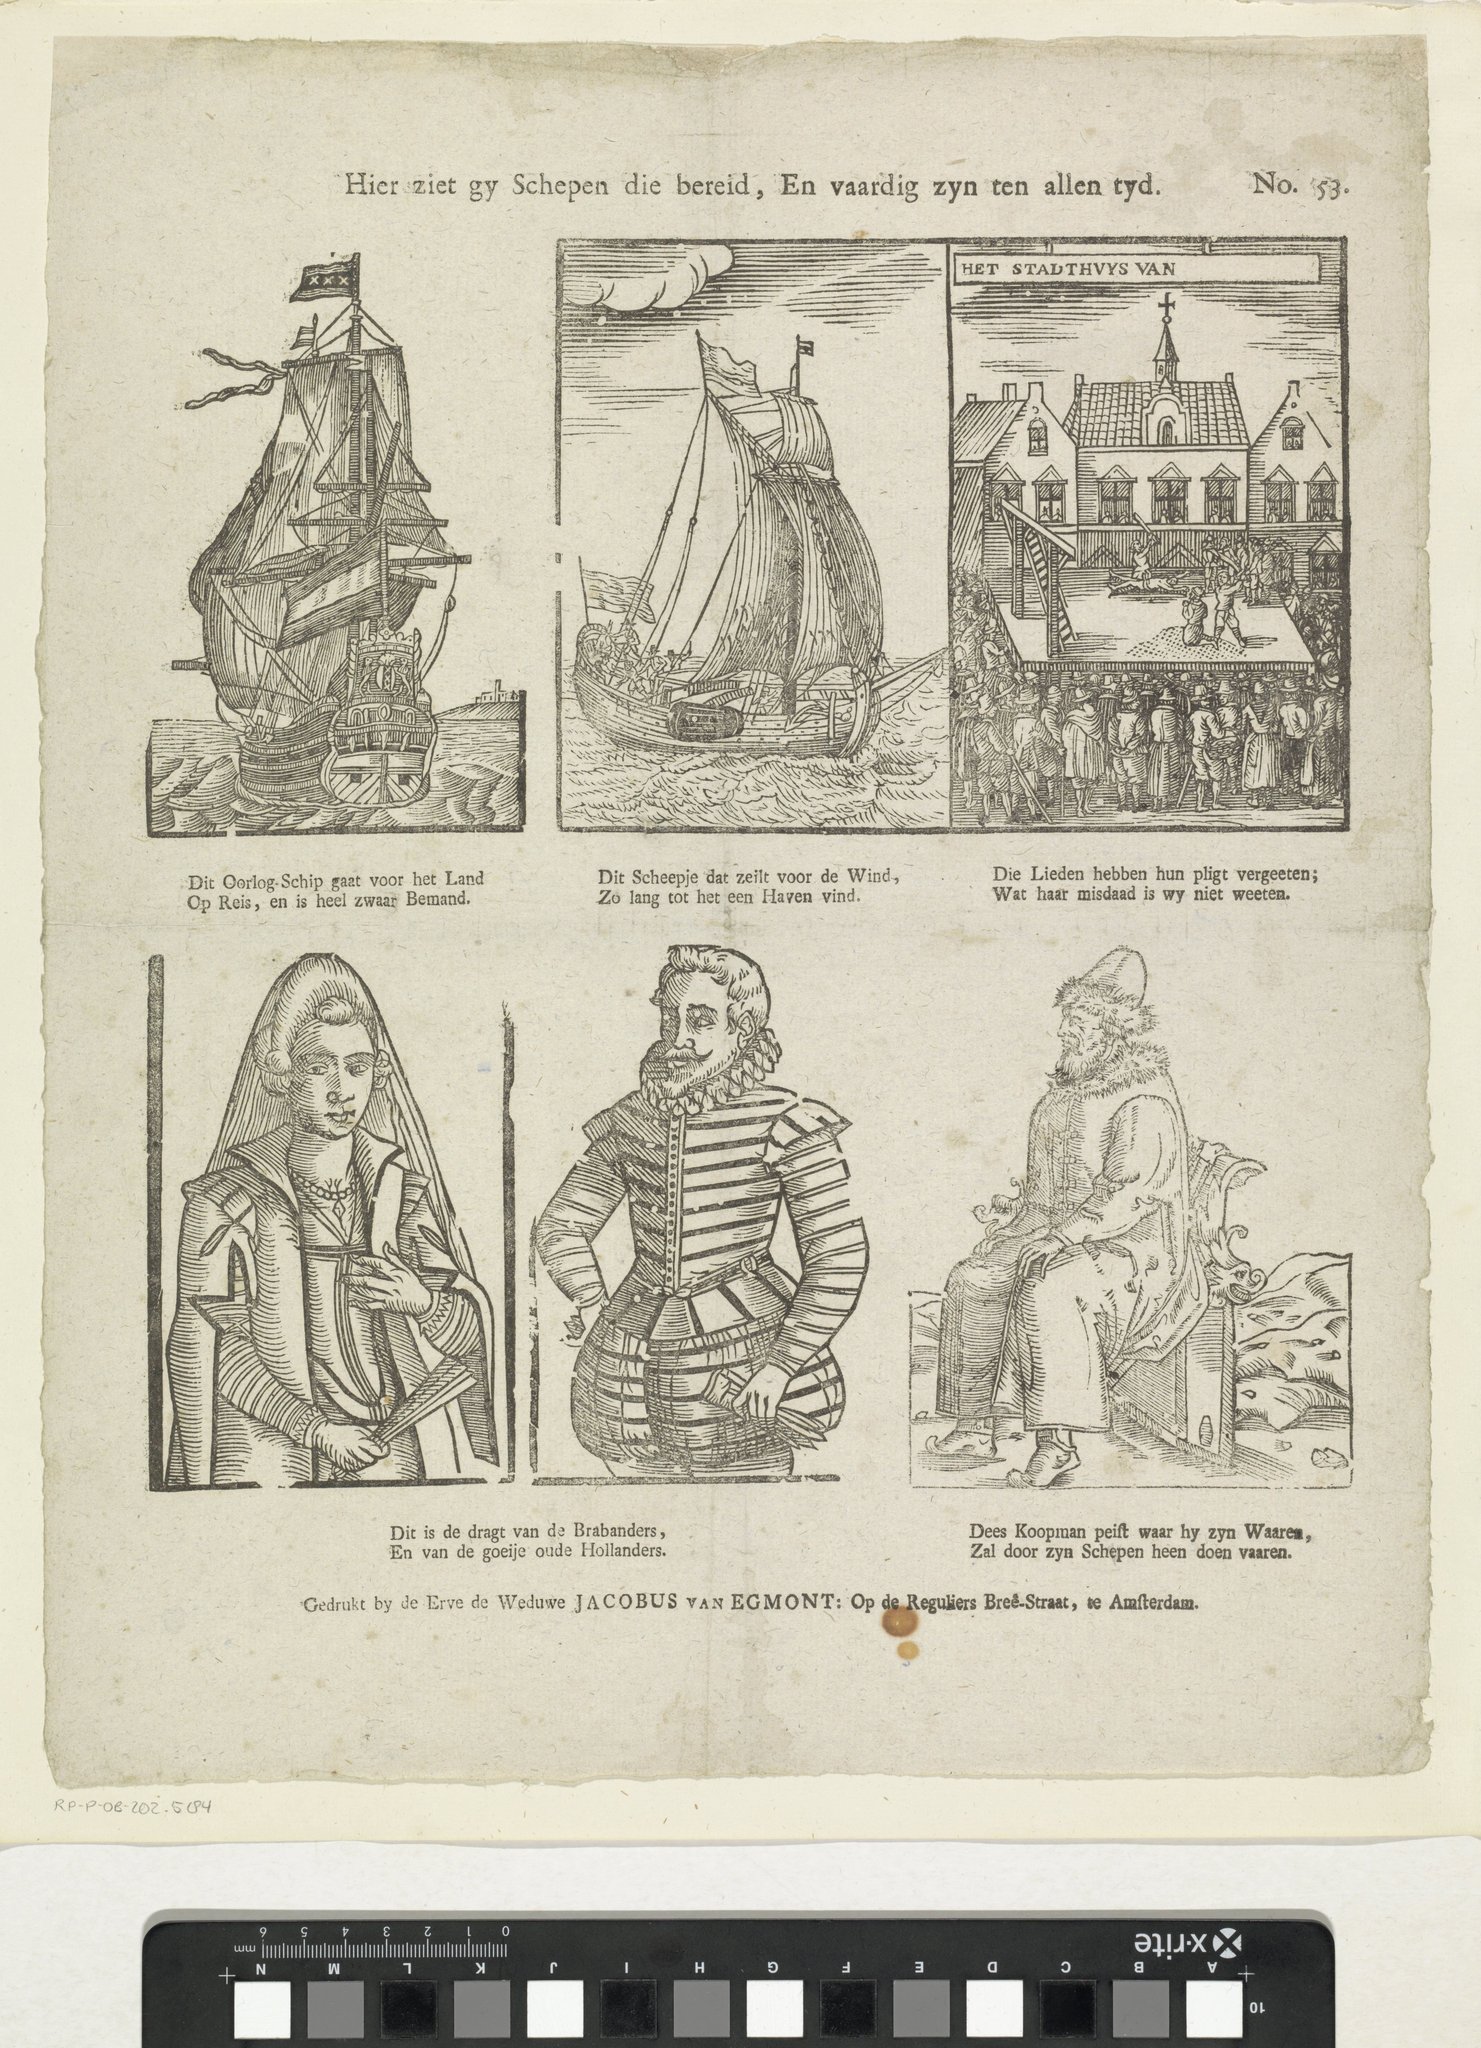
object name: popular print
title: Hier ziet gy schepen die bereid, en vaardig zyn ten allen tyd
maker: Anonymous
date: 1761-1804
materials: paper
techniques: letterpress printing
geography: amsterdam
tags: ships (in general), folk costume, regional costume, public punishment (death not intended or involved)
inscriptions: collector's mark: Lugt 2760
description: Blad met 6 voorstellingen van twee schepen, misdadigers die gestraft worden, figuren in Nederlandse klederdracht en een koopman. Onder elke voorstelling een onderschrift. Genummerd rechtsboven: no. 53.